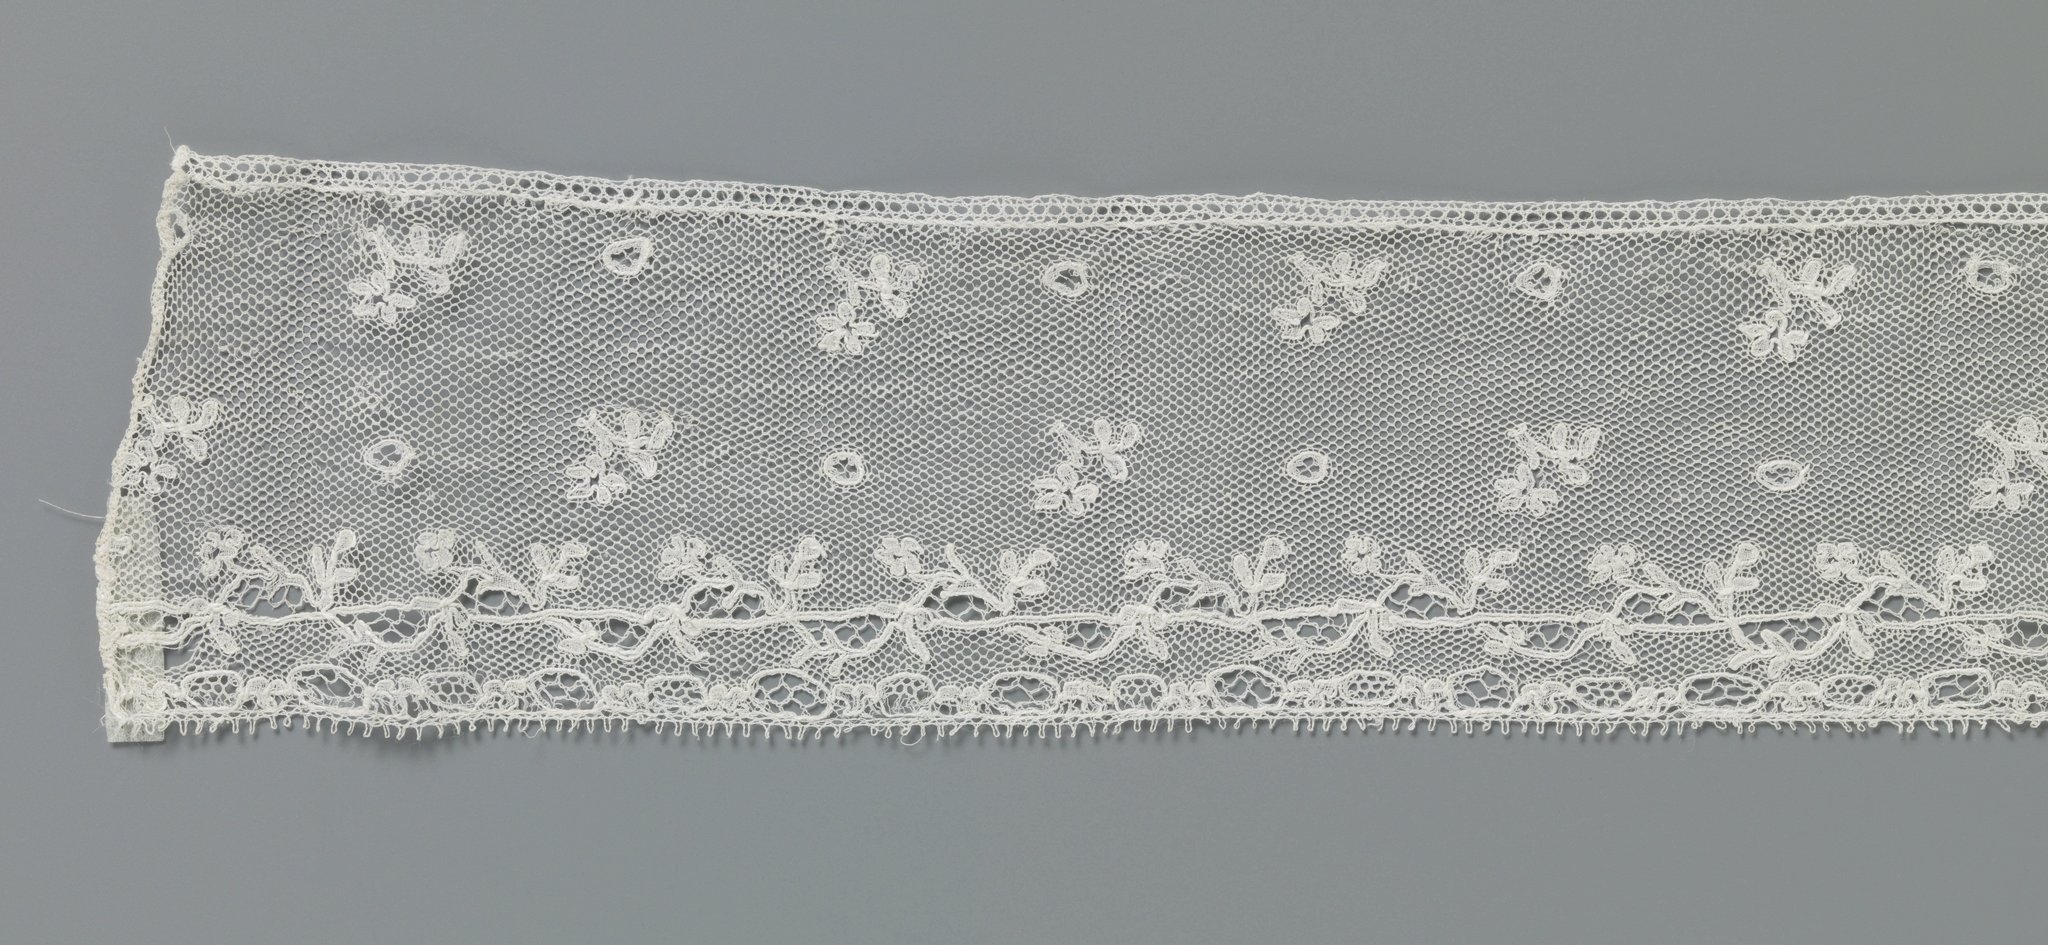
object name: strip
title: Strook kloskant met fijne slinger om rechte lijn onder strooipatroon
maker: Anonymous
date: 1800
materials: linen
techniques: lace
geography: southern netherlands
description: Strook naturelkleurige kloskant: Mechelse kant. Het bovenste deel van de strook bestaat uit twee rijen van afwisselend een opengewerkt rondje en een hangend stervormig bloempje met drie blaadjes aan een afgesplitst steeltje. Langs het onderste deel van de strook loopt een rechte lijn waar een rank omheen slingert met fijne bloempjes en blaadjes. Direct hieronder ligt langs de onderzijde van de strook een aaneenschakeling van ovaaltjes, steeds met één drielobbig blaadje ertussen. Het motieven zijn gemaakt in linnenslag, met dikkere en glimmende contourdraden. De motieven zijn met elkaar verbonden door een fijne maasgrond, een Mechelse grond. De bovenzijde van de strook is afgewerkt met een apart geklost bandje. De onderzijde van de strook is recht afgewerkt en voorzien van picots. De korte zijden zijn afgewerkt met een zoompje.